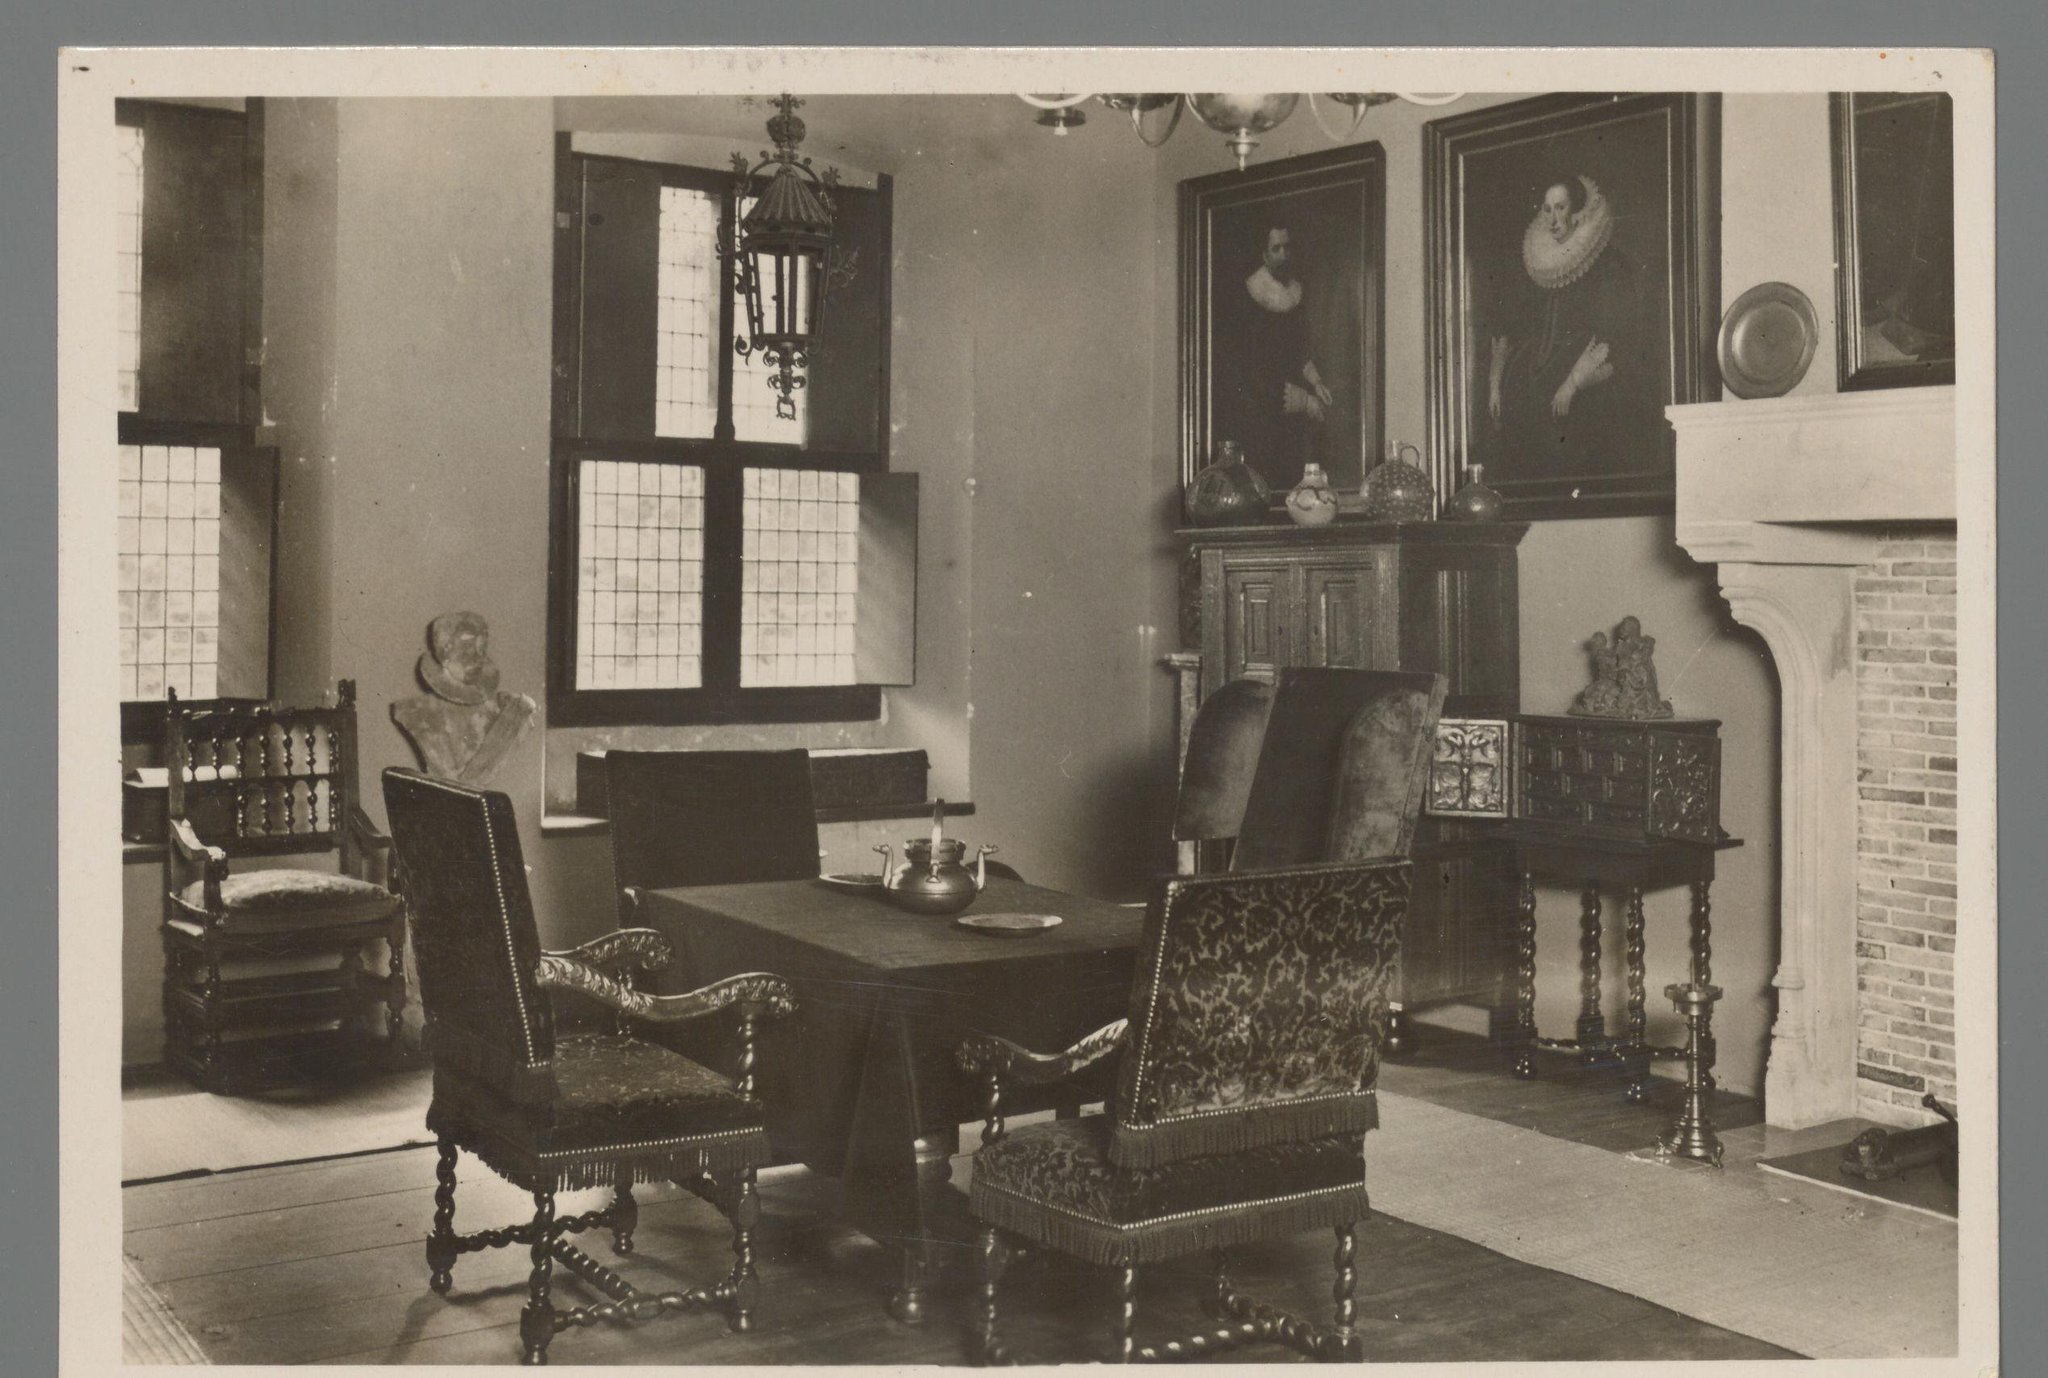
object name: photograph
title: Loosdrecht. Kasteel - Museum Sijpesteijn. Lage Zaal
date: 1929-1941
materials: paper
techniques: gelatin silver print, writing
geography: arnhem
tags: castle, interior of the house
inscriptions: postage stamp